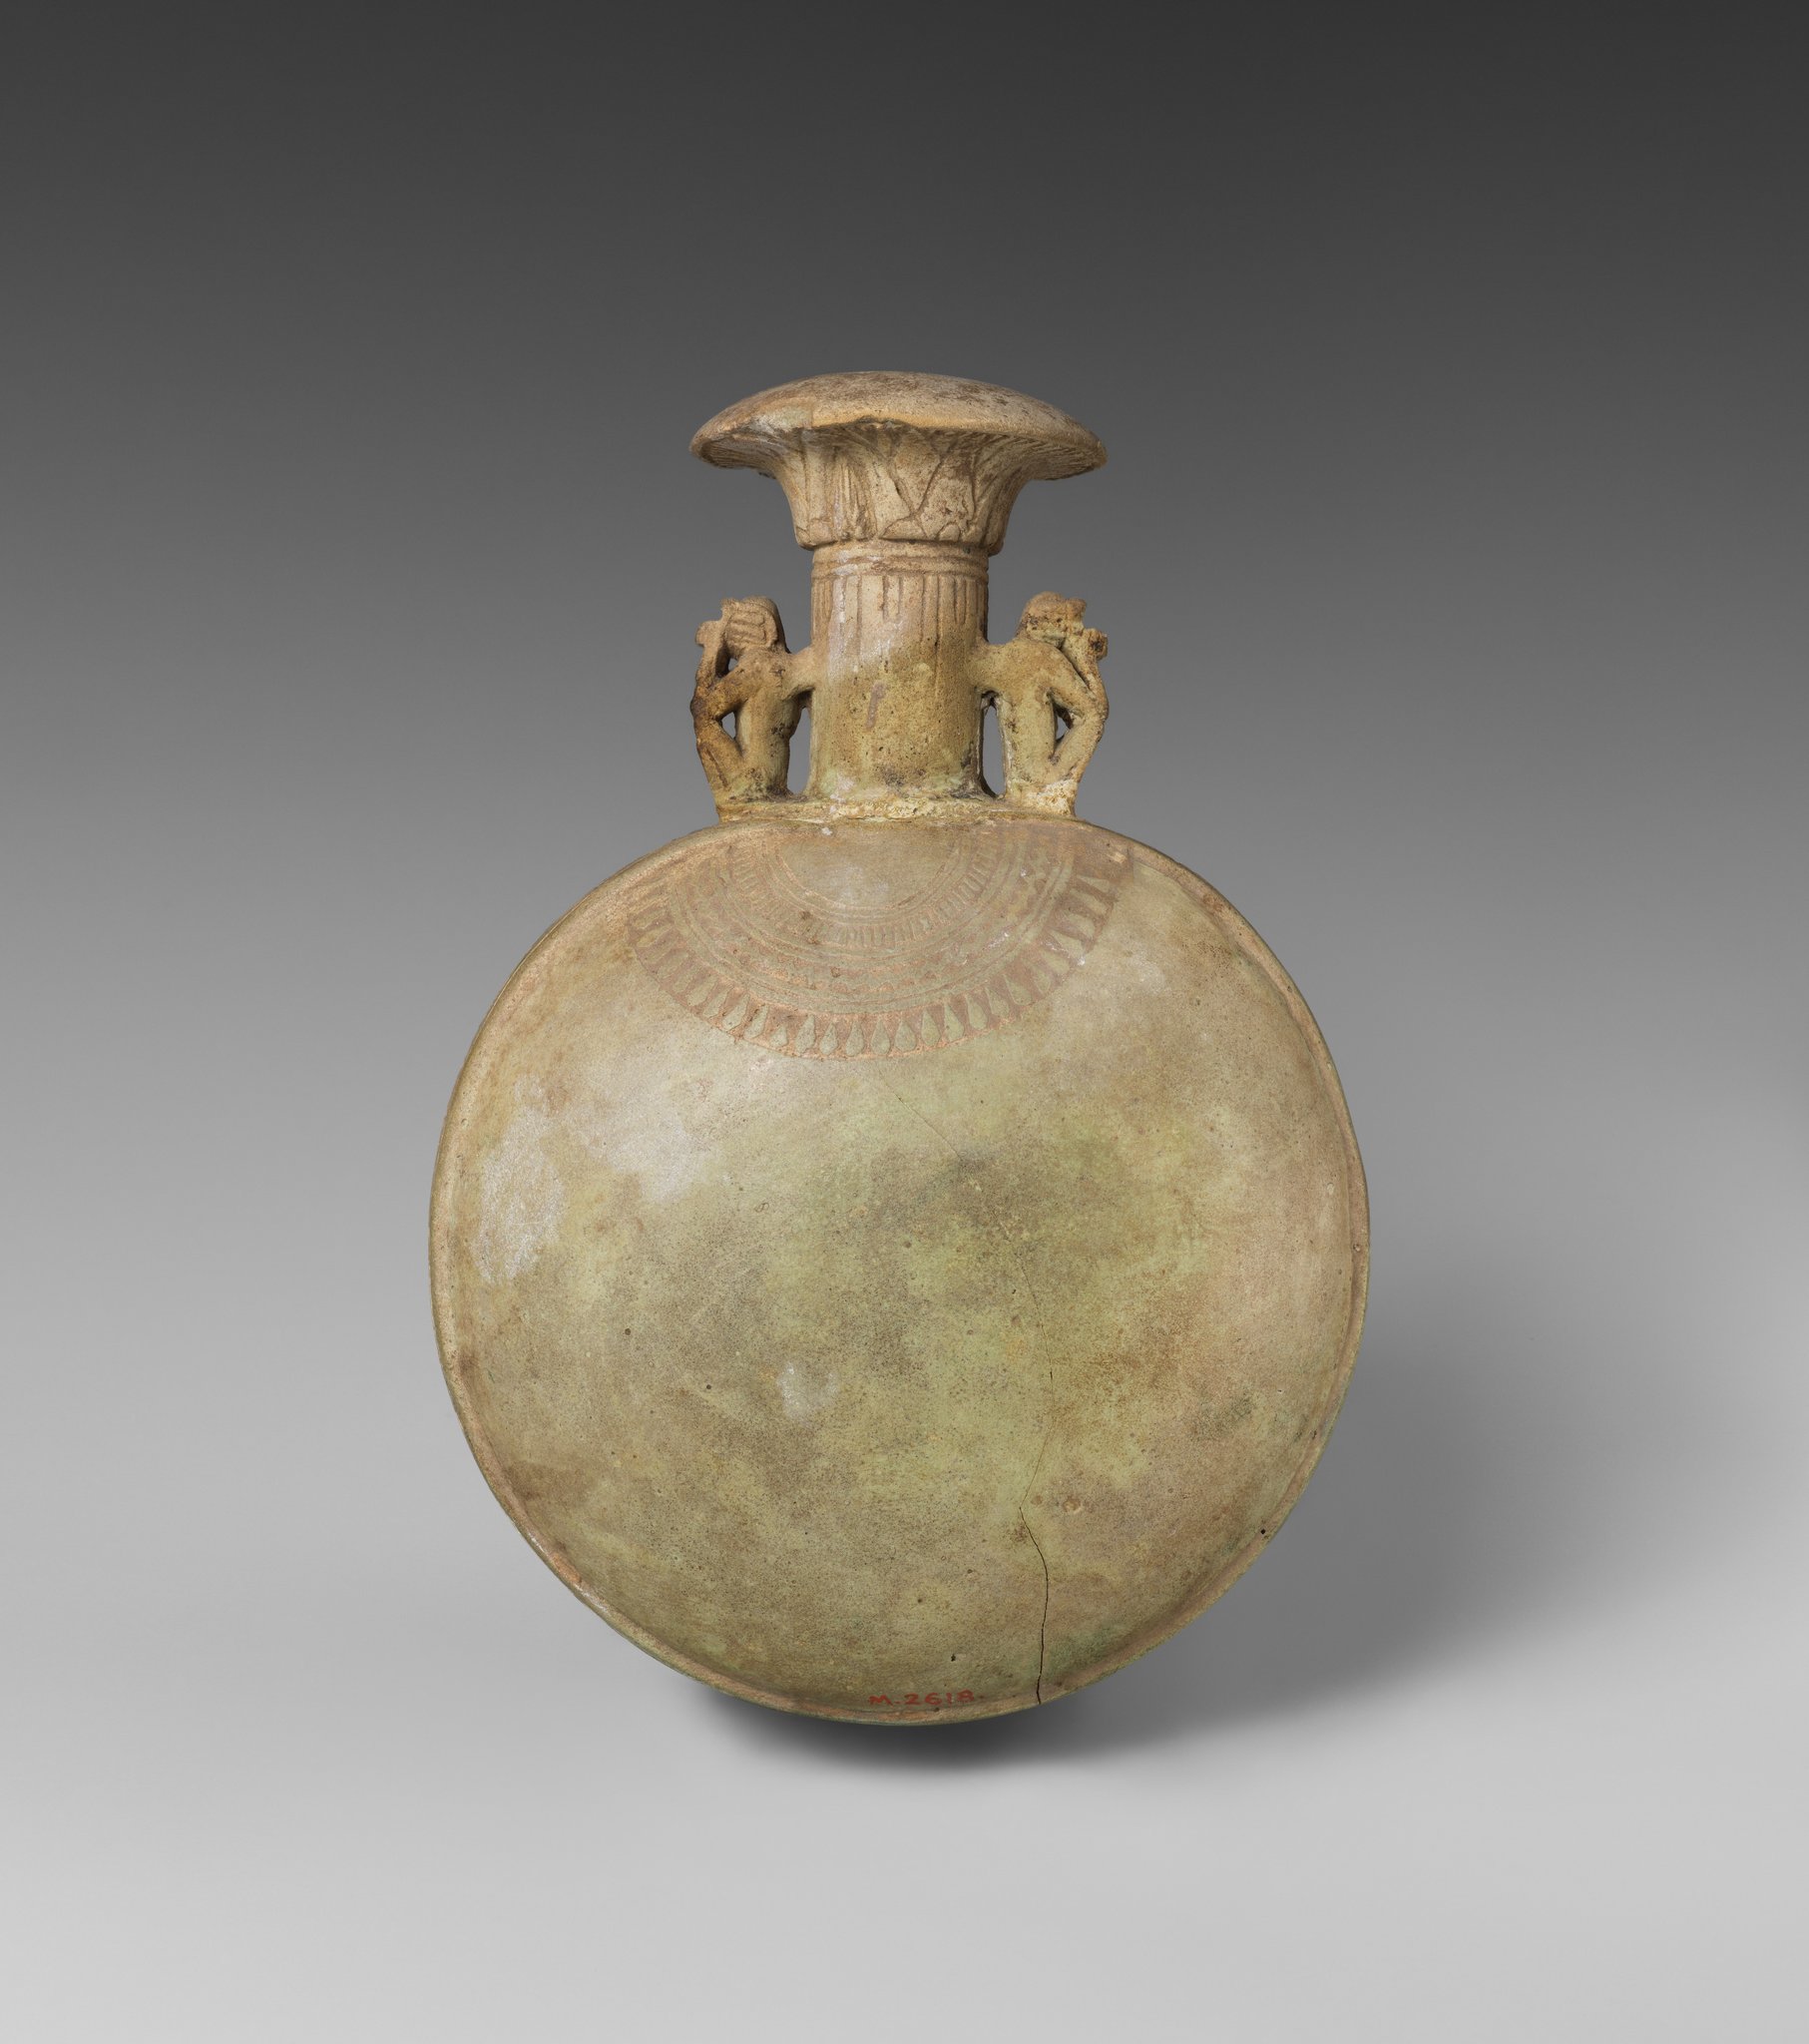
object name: lentoid bottle, new year's bottle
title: Lentoid Bottle ("New Year's Bottle")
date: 664-332 BCE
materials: faience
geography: egypt